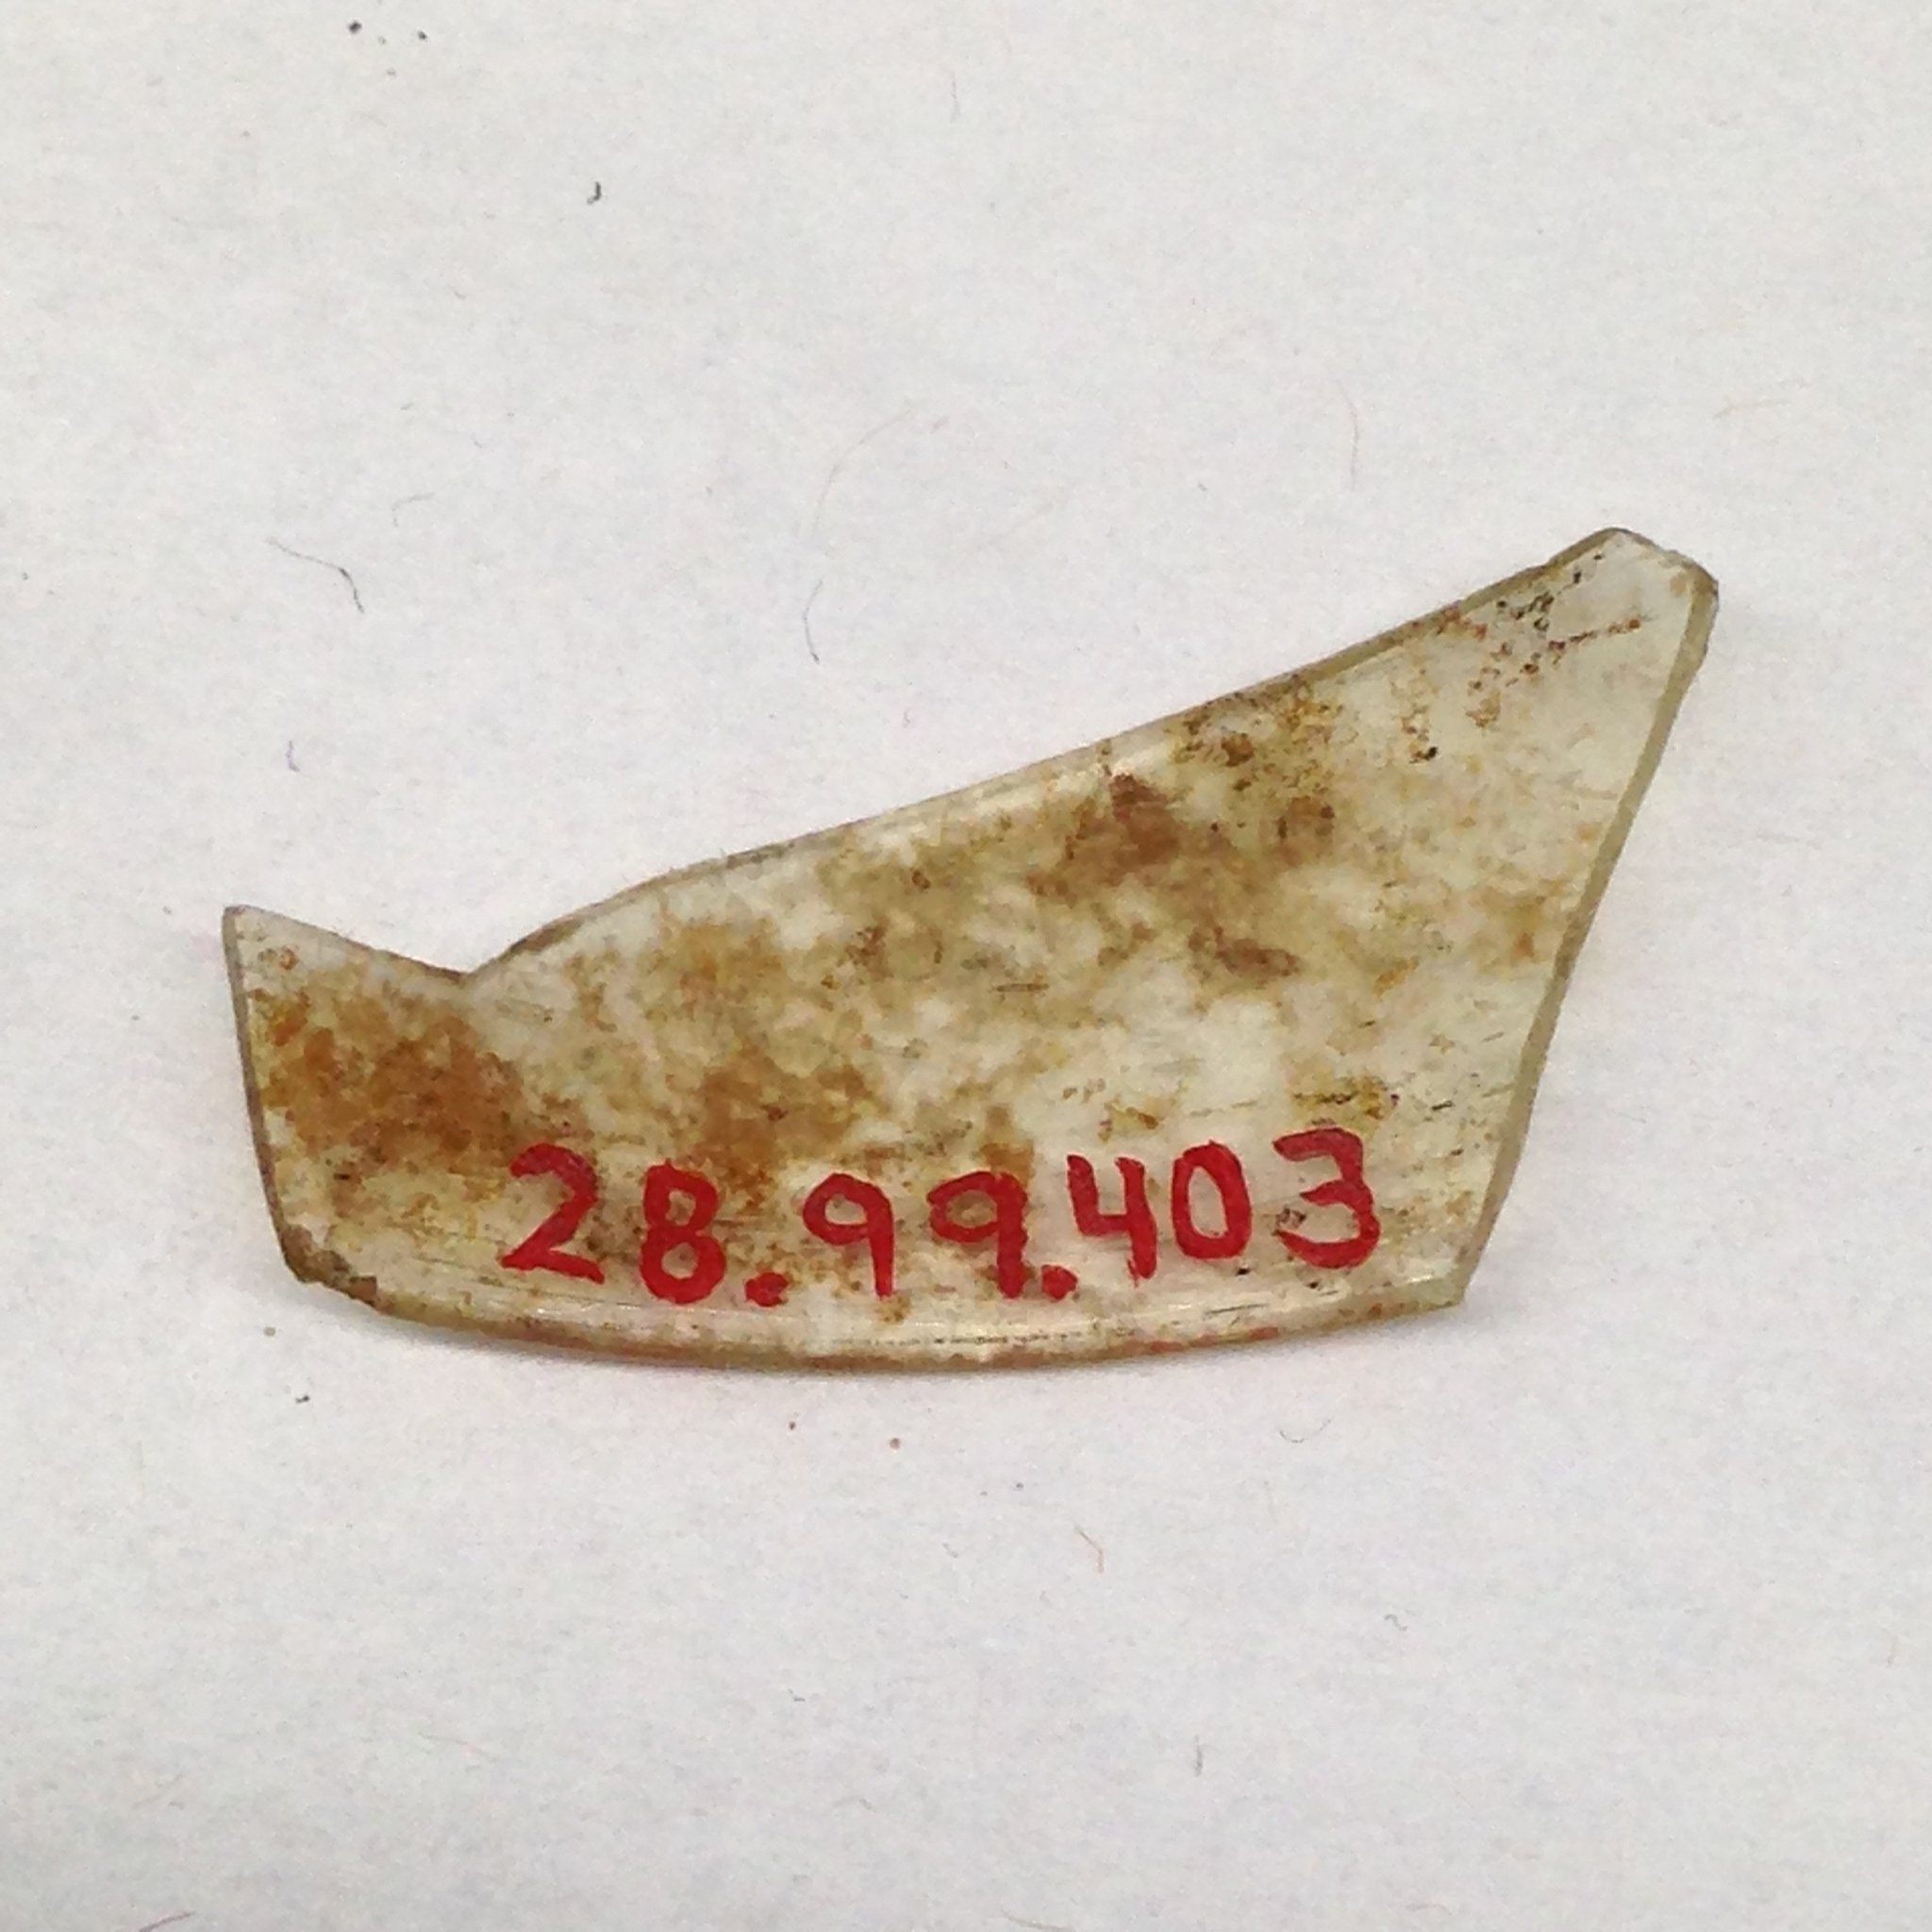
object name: fragment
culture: european or middle eastern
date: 1150-1250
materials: ceramic, glass